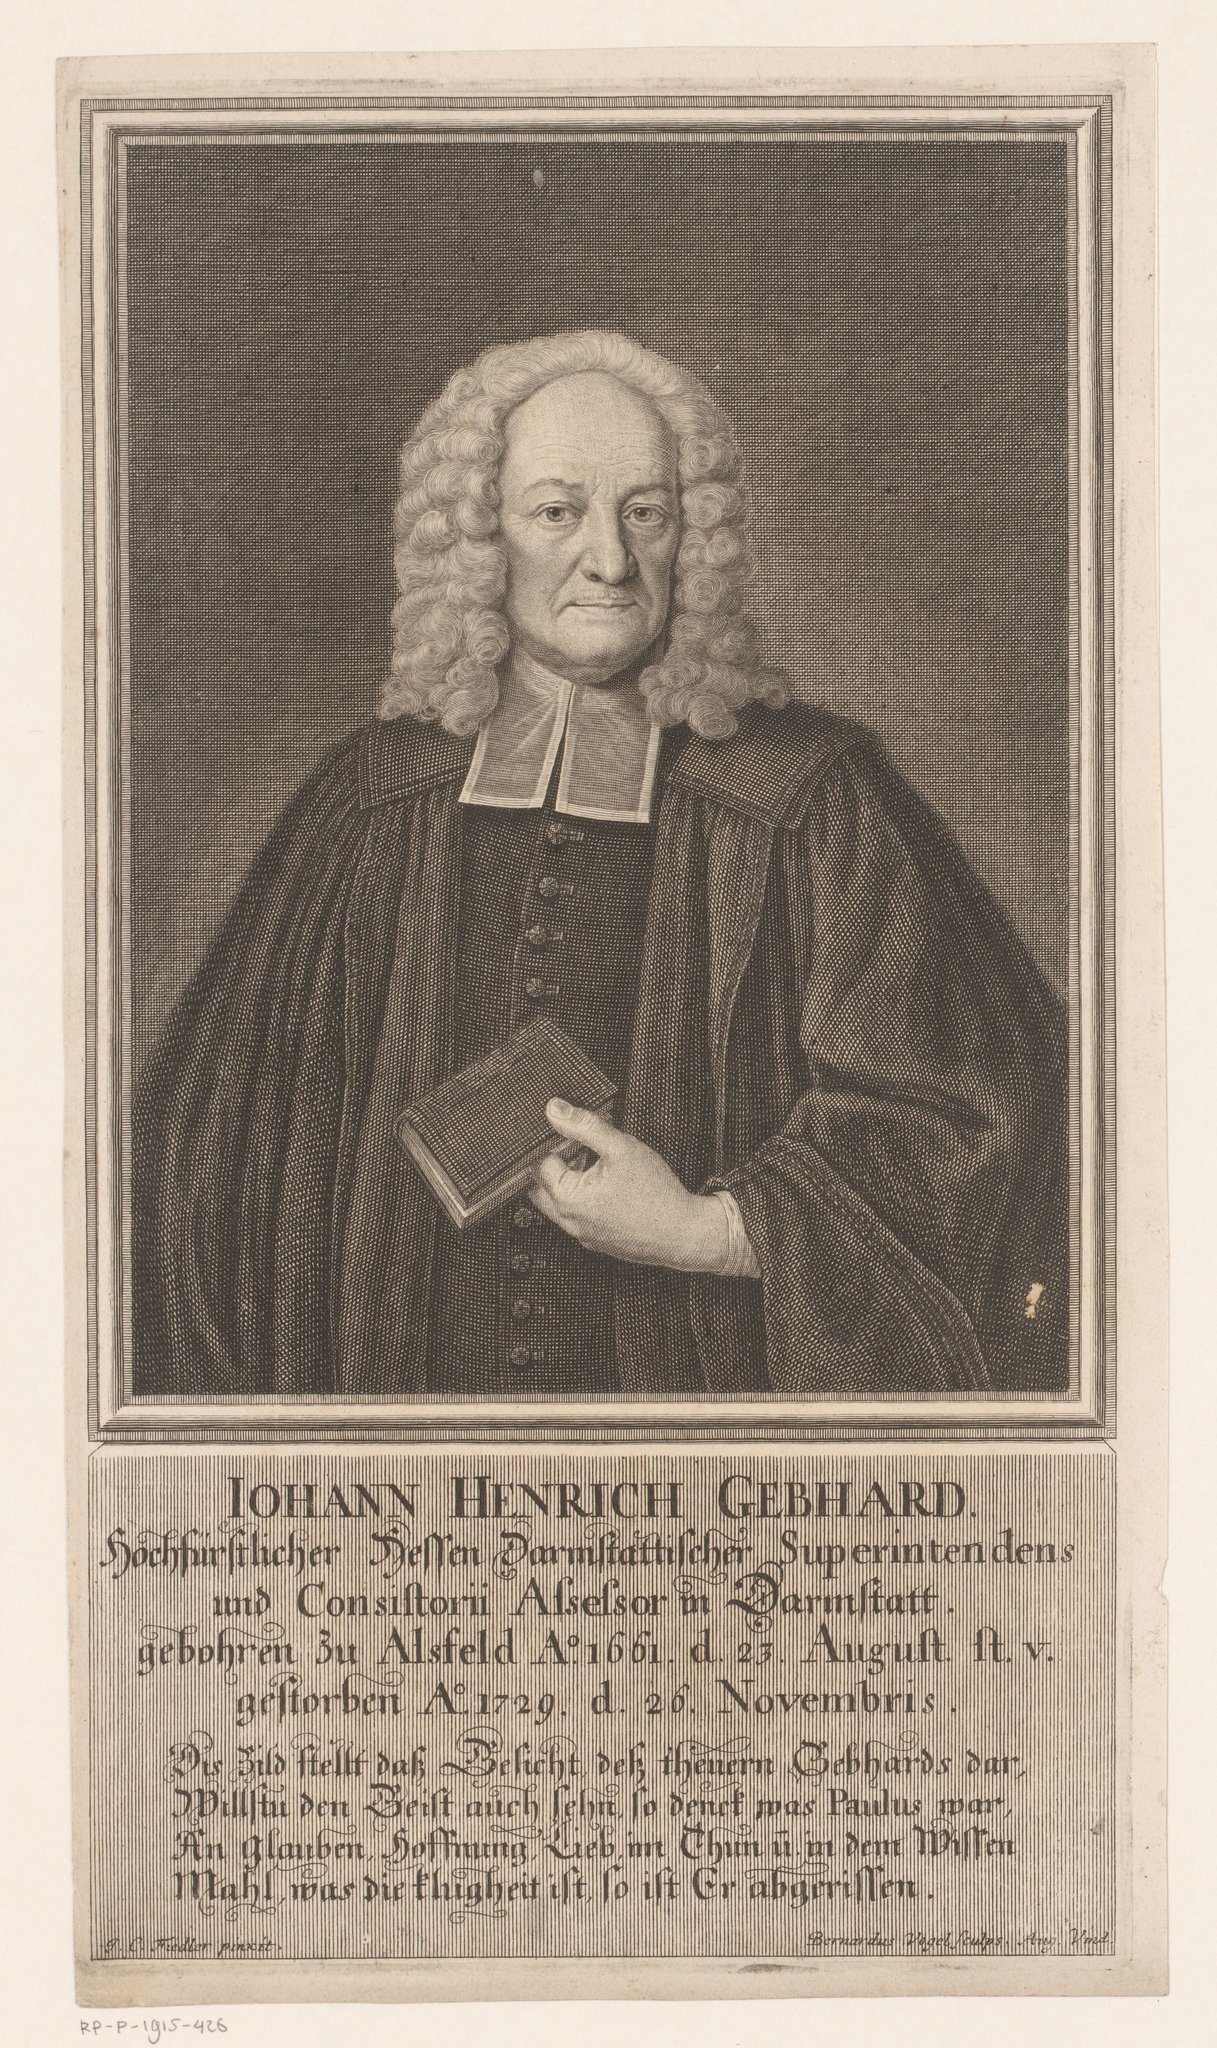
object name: print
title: Portret van Johann Henrich Gebhard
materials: paper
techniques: engraving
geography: augsburg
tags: historical persons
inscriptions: collector's mark: Lugt 2228